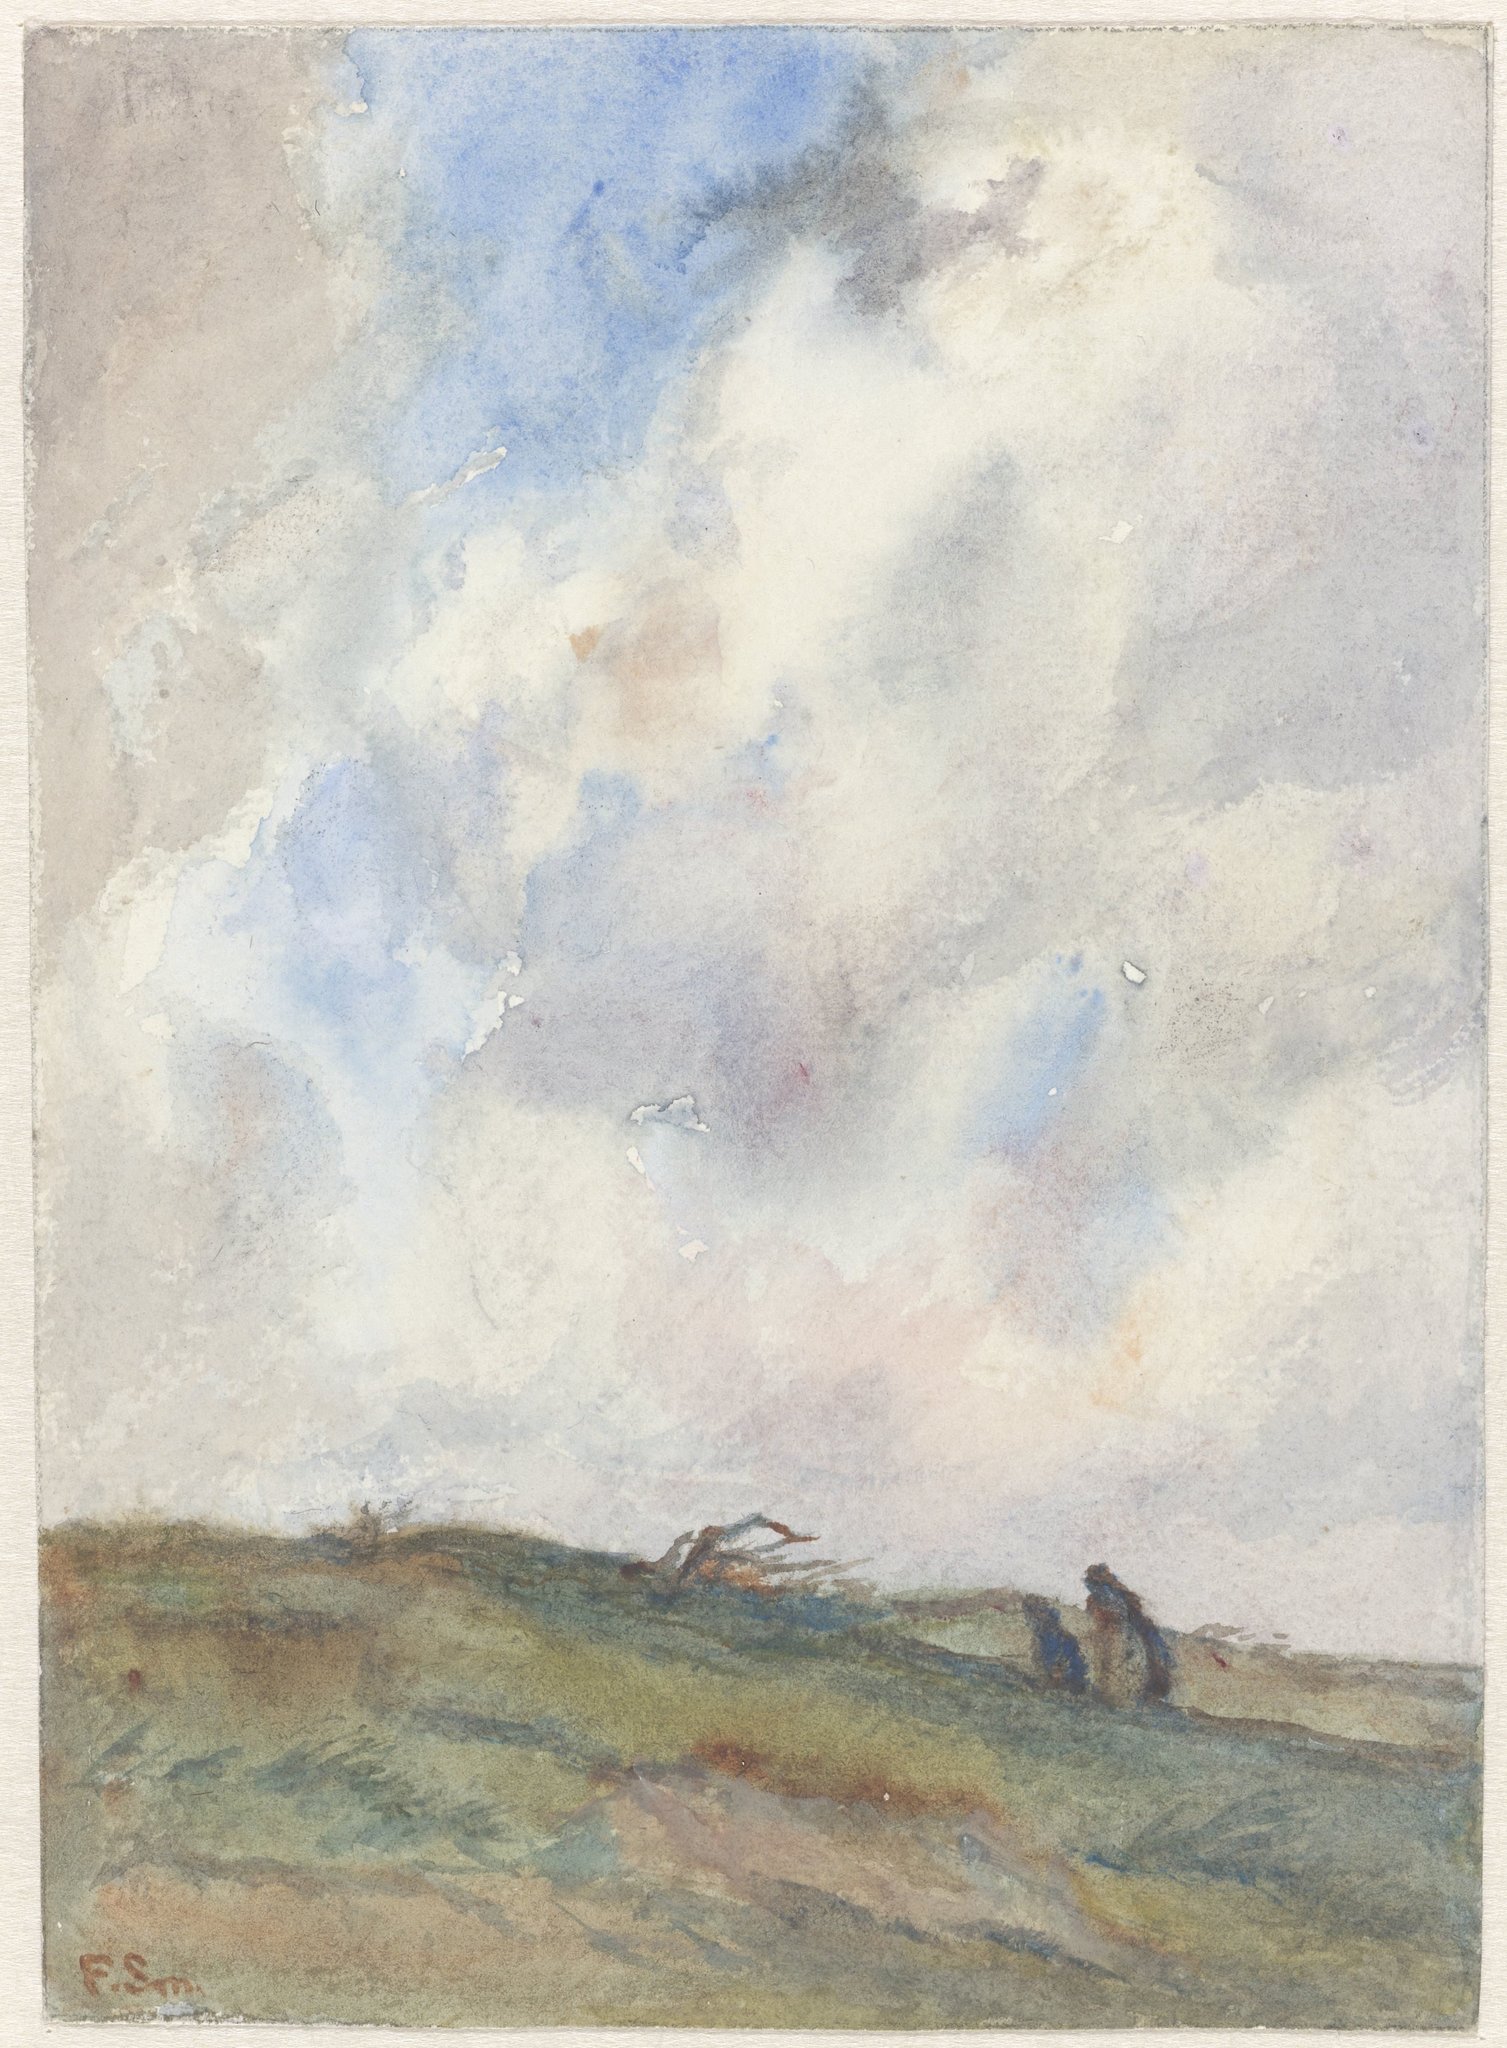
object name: watercolor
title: Duinlandschap bij storm met twee figuren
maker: frans smissaert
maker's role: draughtsman, print maker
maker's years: 1862-1944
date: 1872-1944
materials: paper, watercolor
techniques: brush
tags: flying on or with the aid of animal(s), dunes (sea not visible); in the dunes